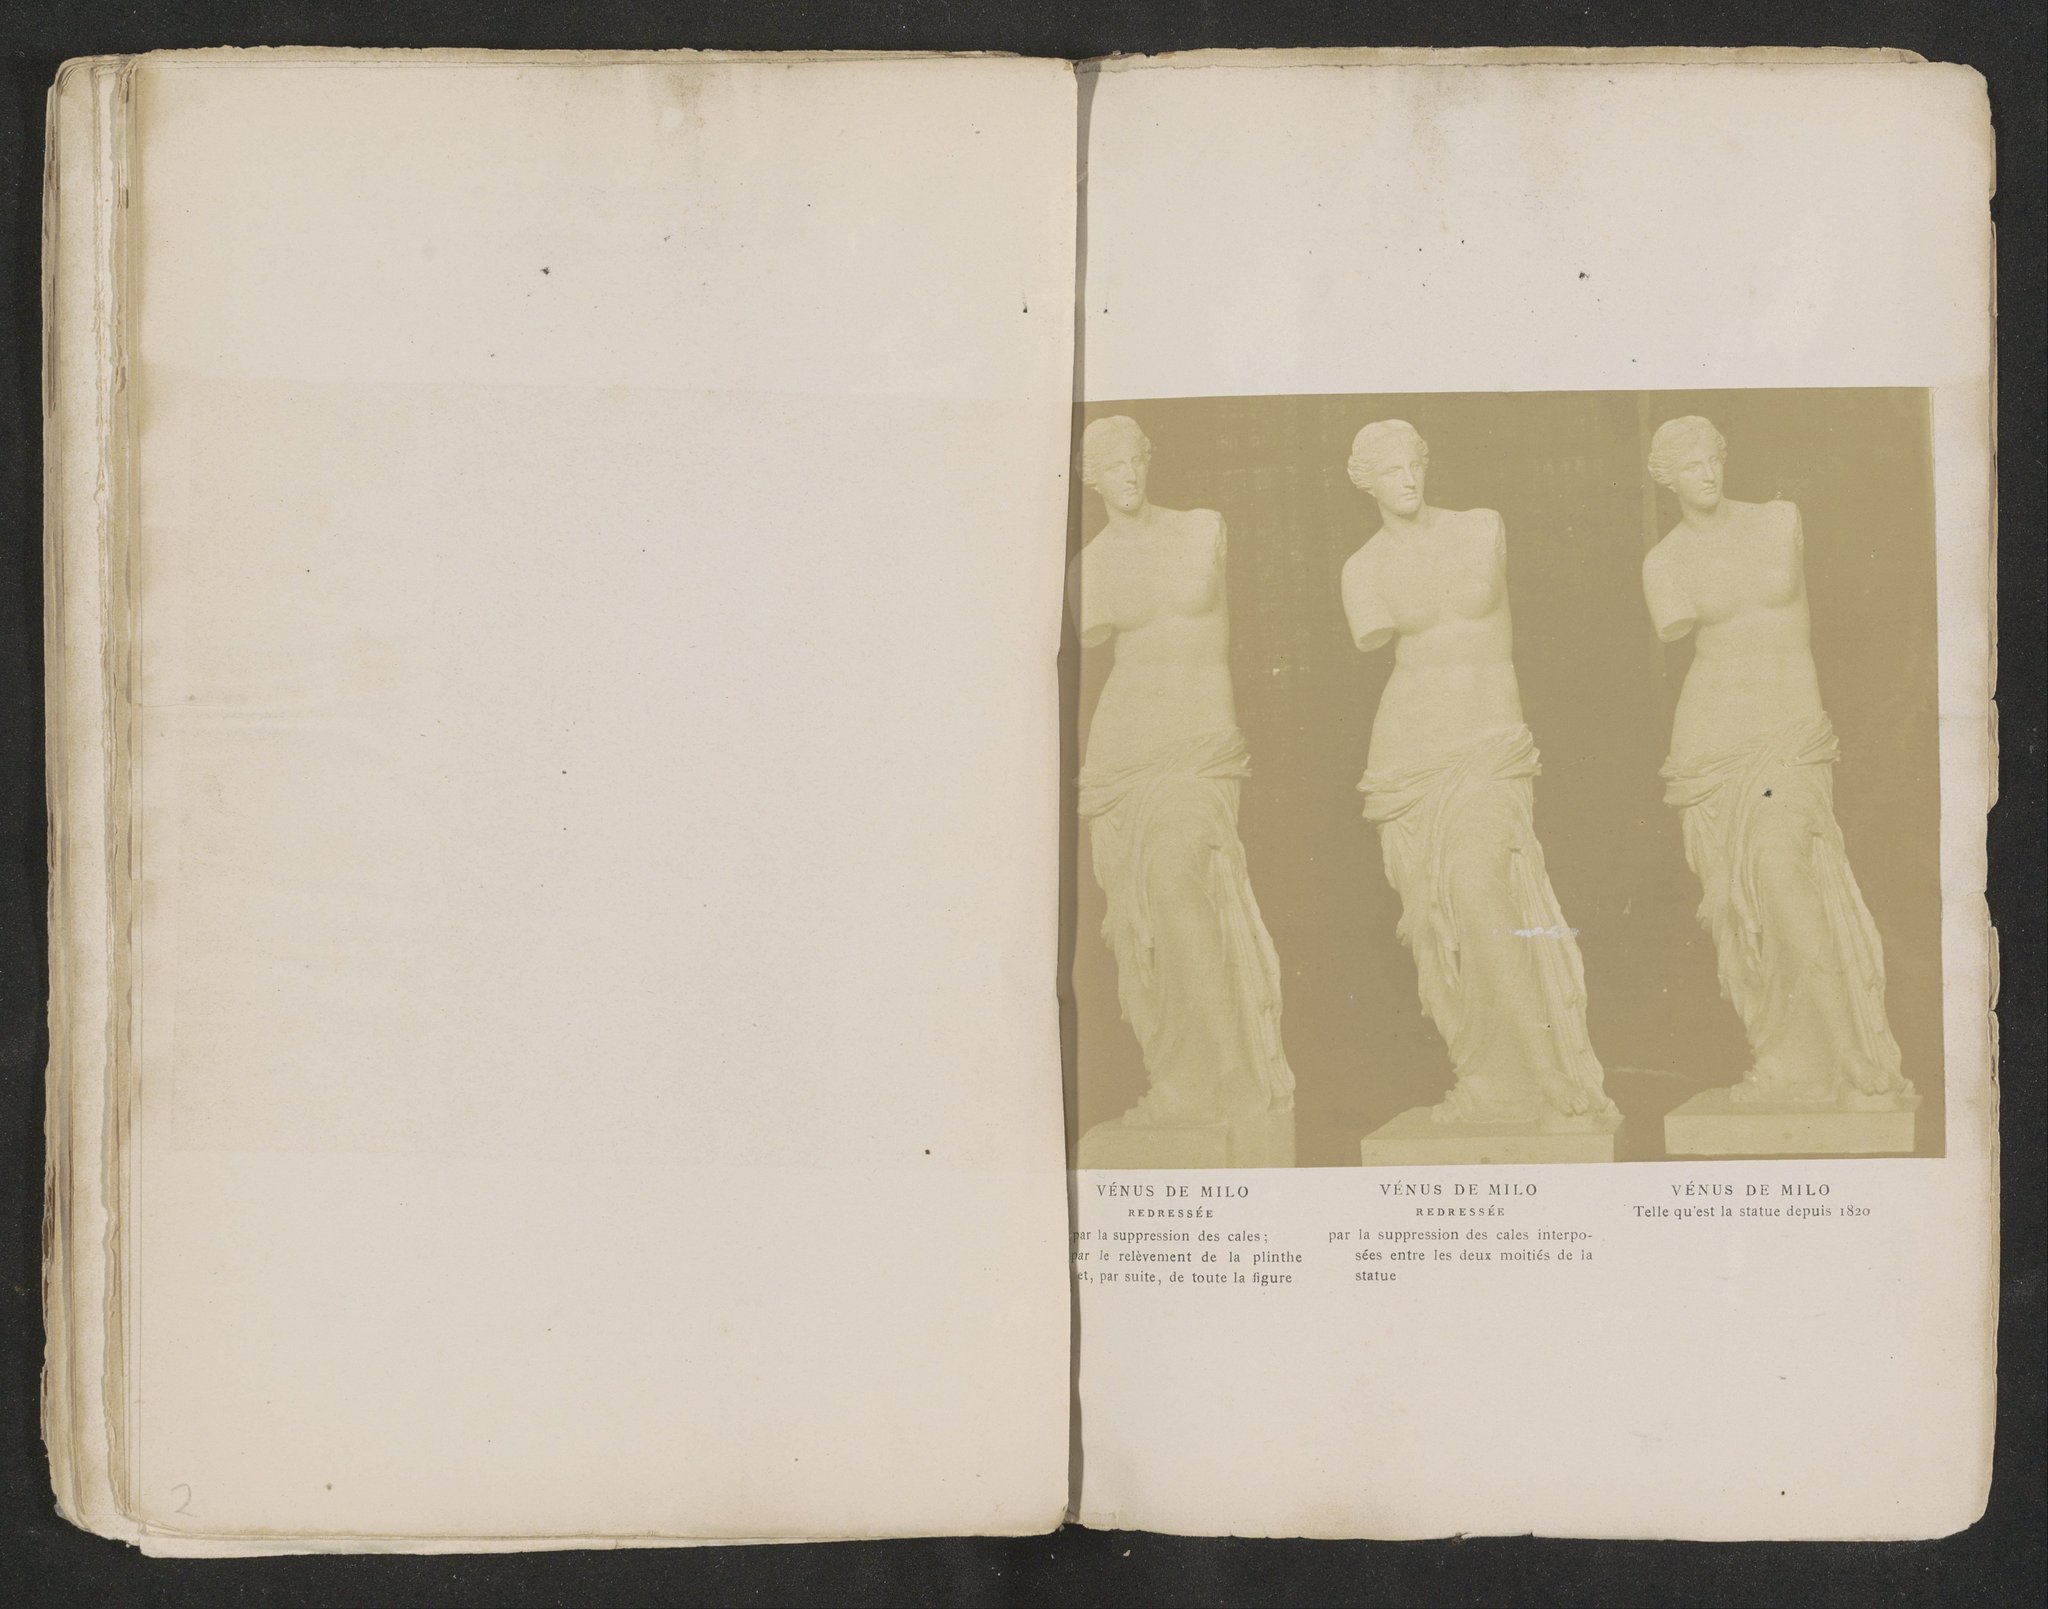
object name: page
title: Venus van Milo in drie stadia van restauratie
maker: Anonymous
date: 1861-1871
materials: photographic support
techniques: albumen print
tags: (story of) venus (aphrodite), sculpture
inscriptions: inscription: ‘redressée par la suppression des cales (...) Telle quést la statue depuis 1820’